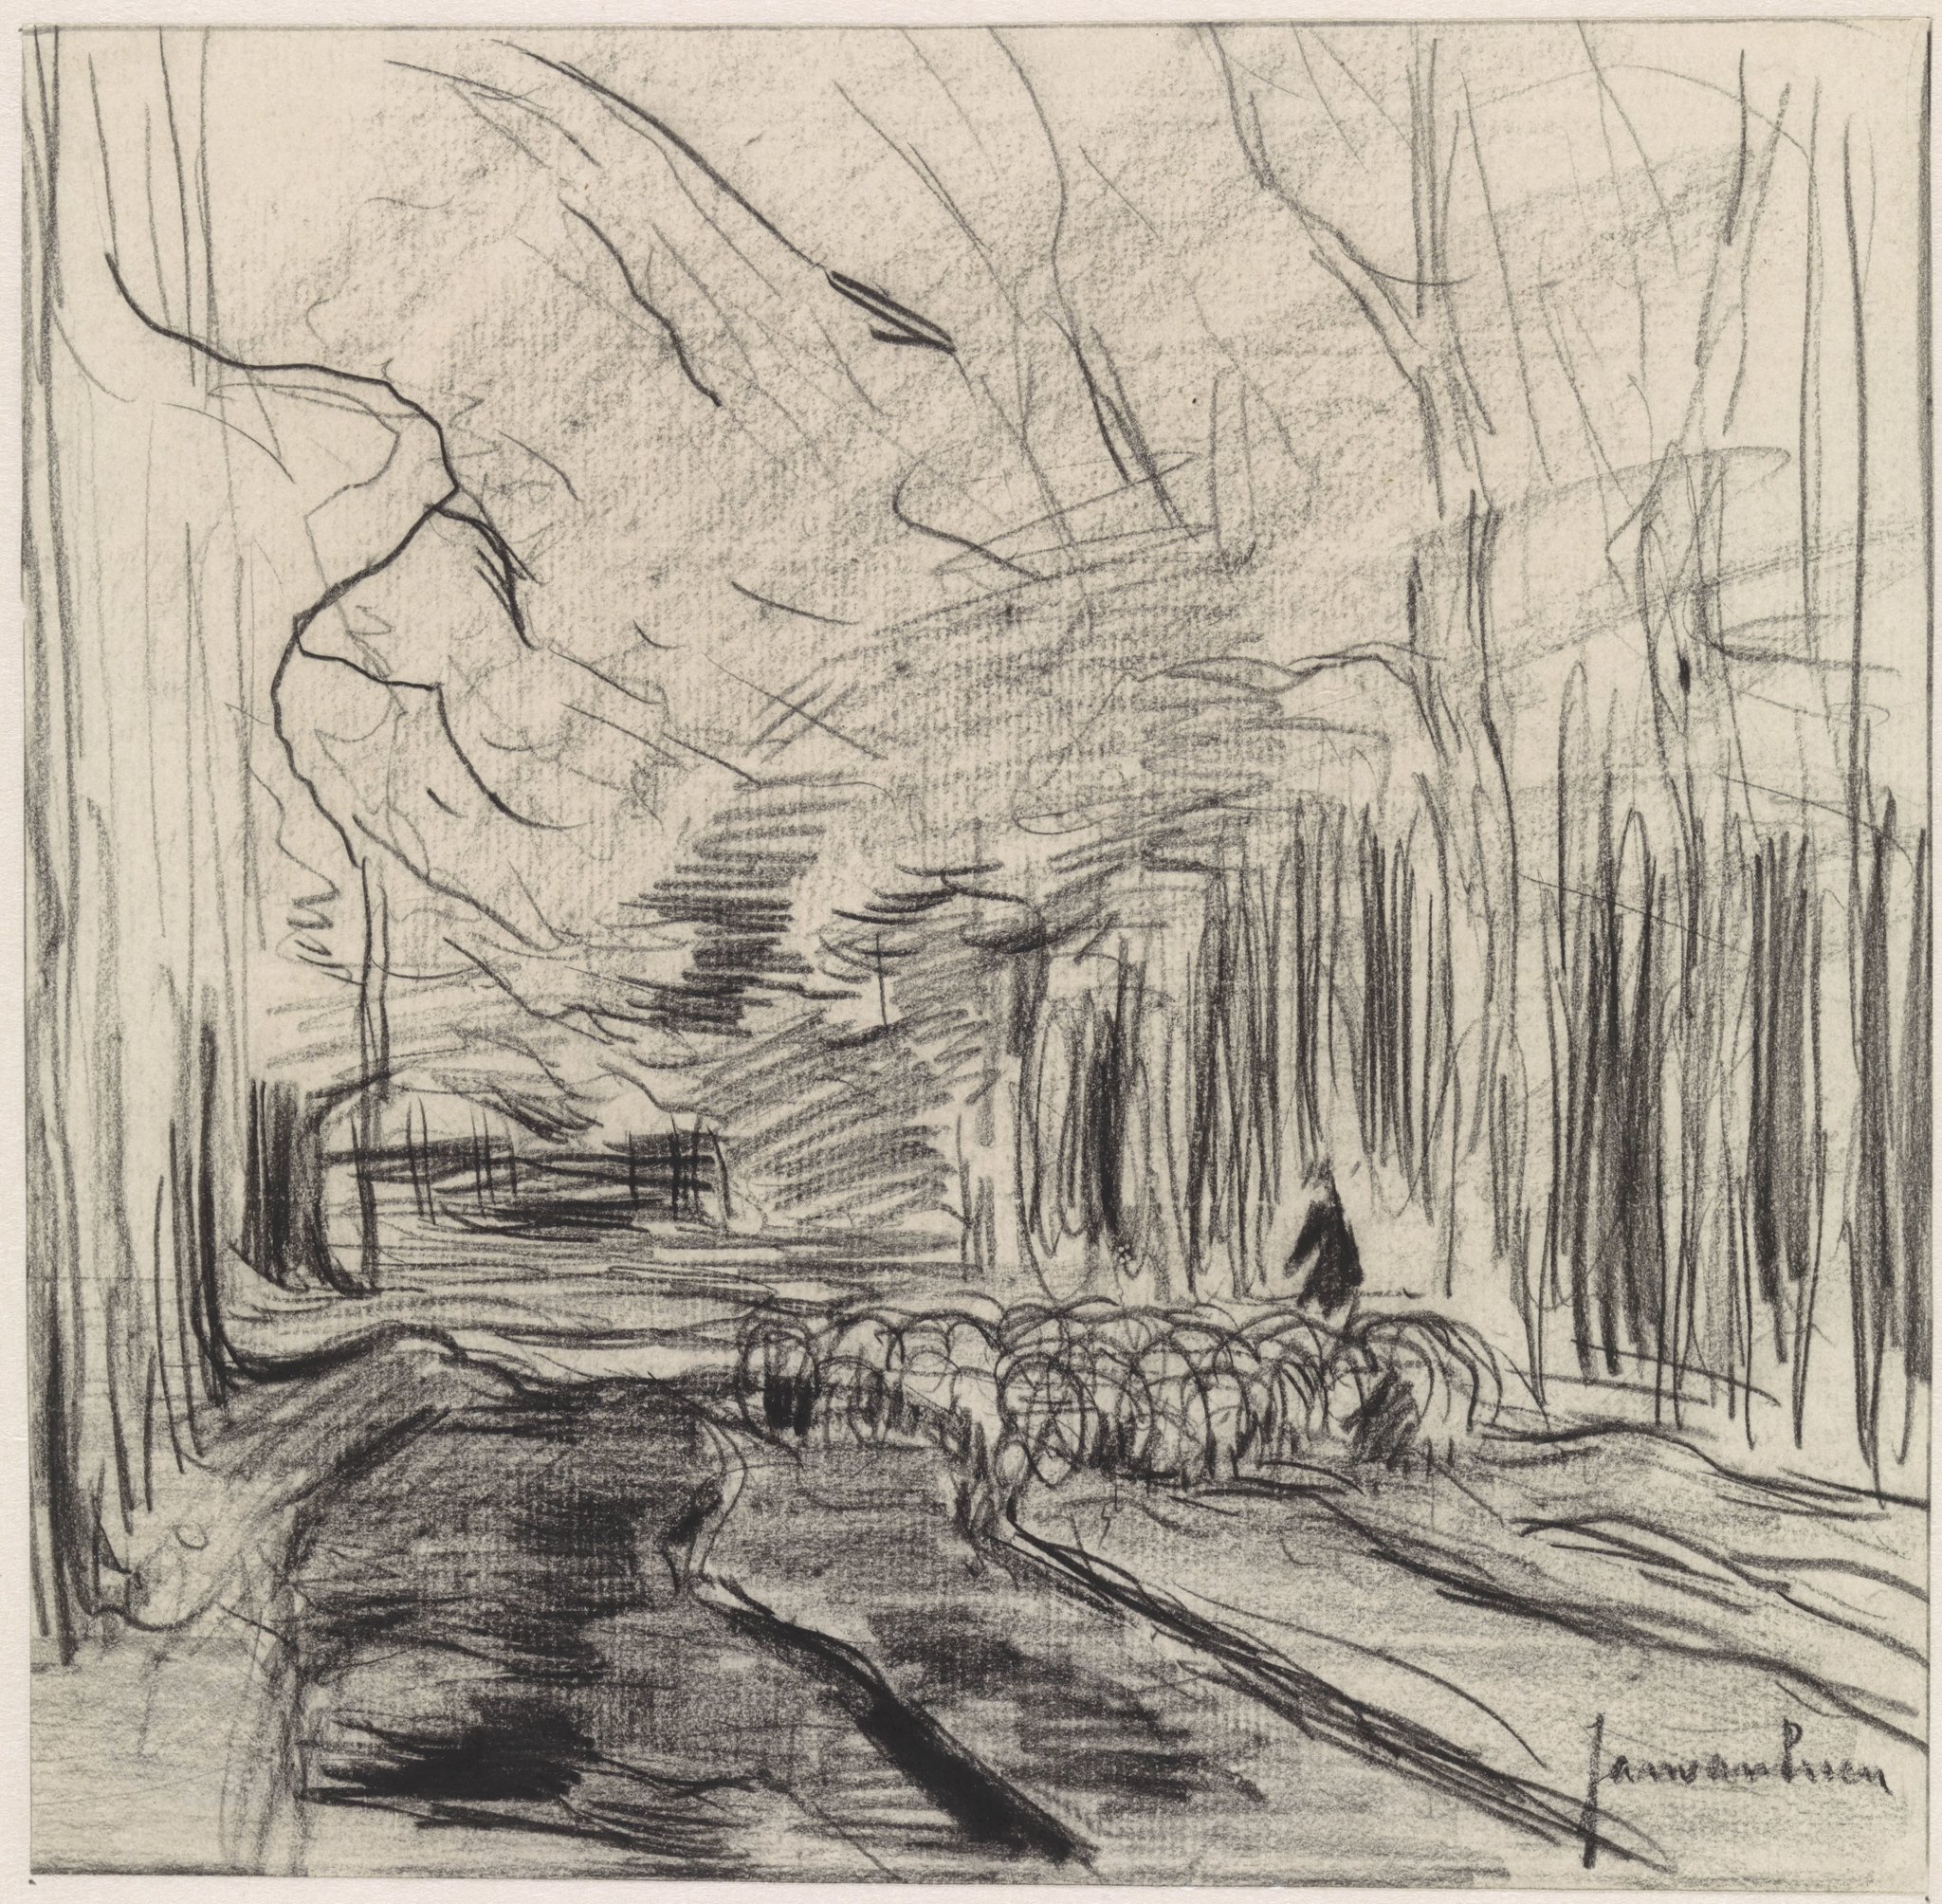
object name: drawing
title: Kudde schapen in een bos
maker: jan van essen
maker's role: draughtsman, print maker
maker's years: 1854-1936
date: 1864-1936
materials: chalk, paper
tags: sheep